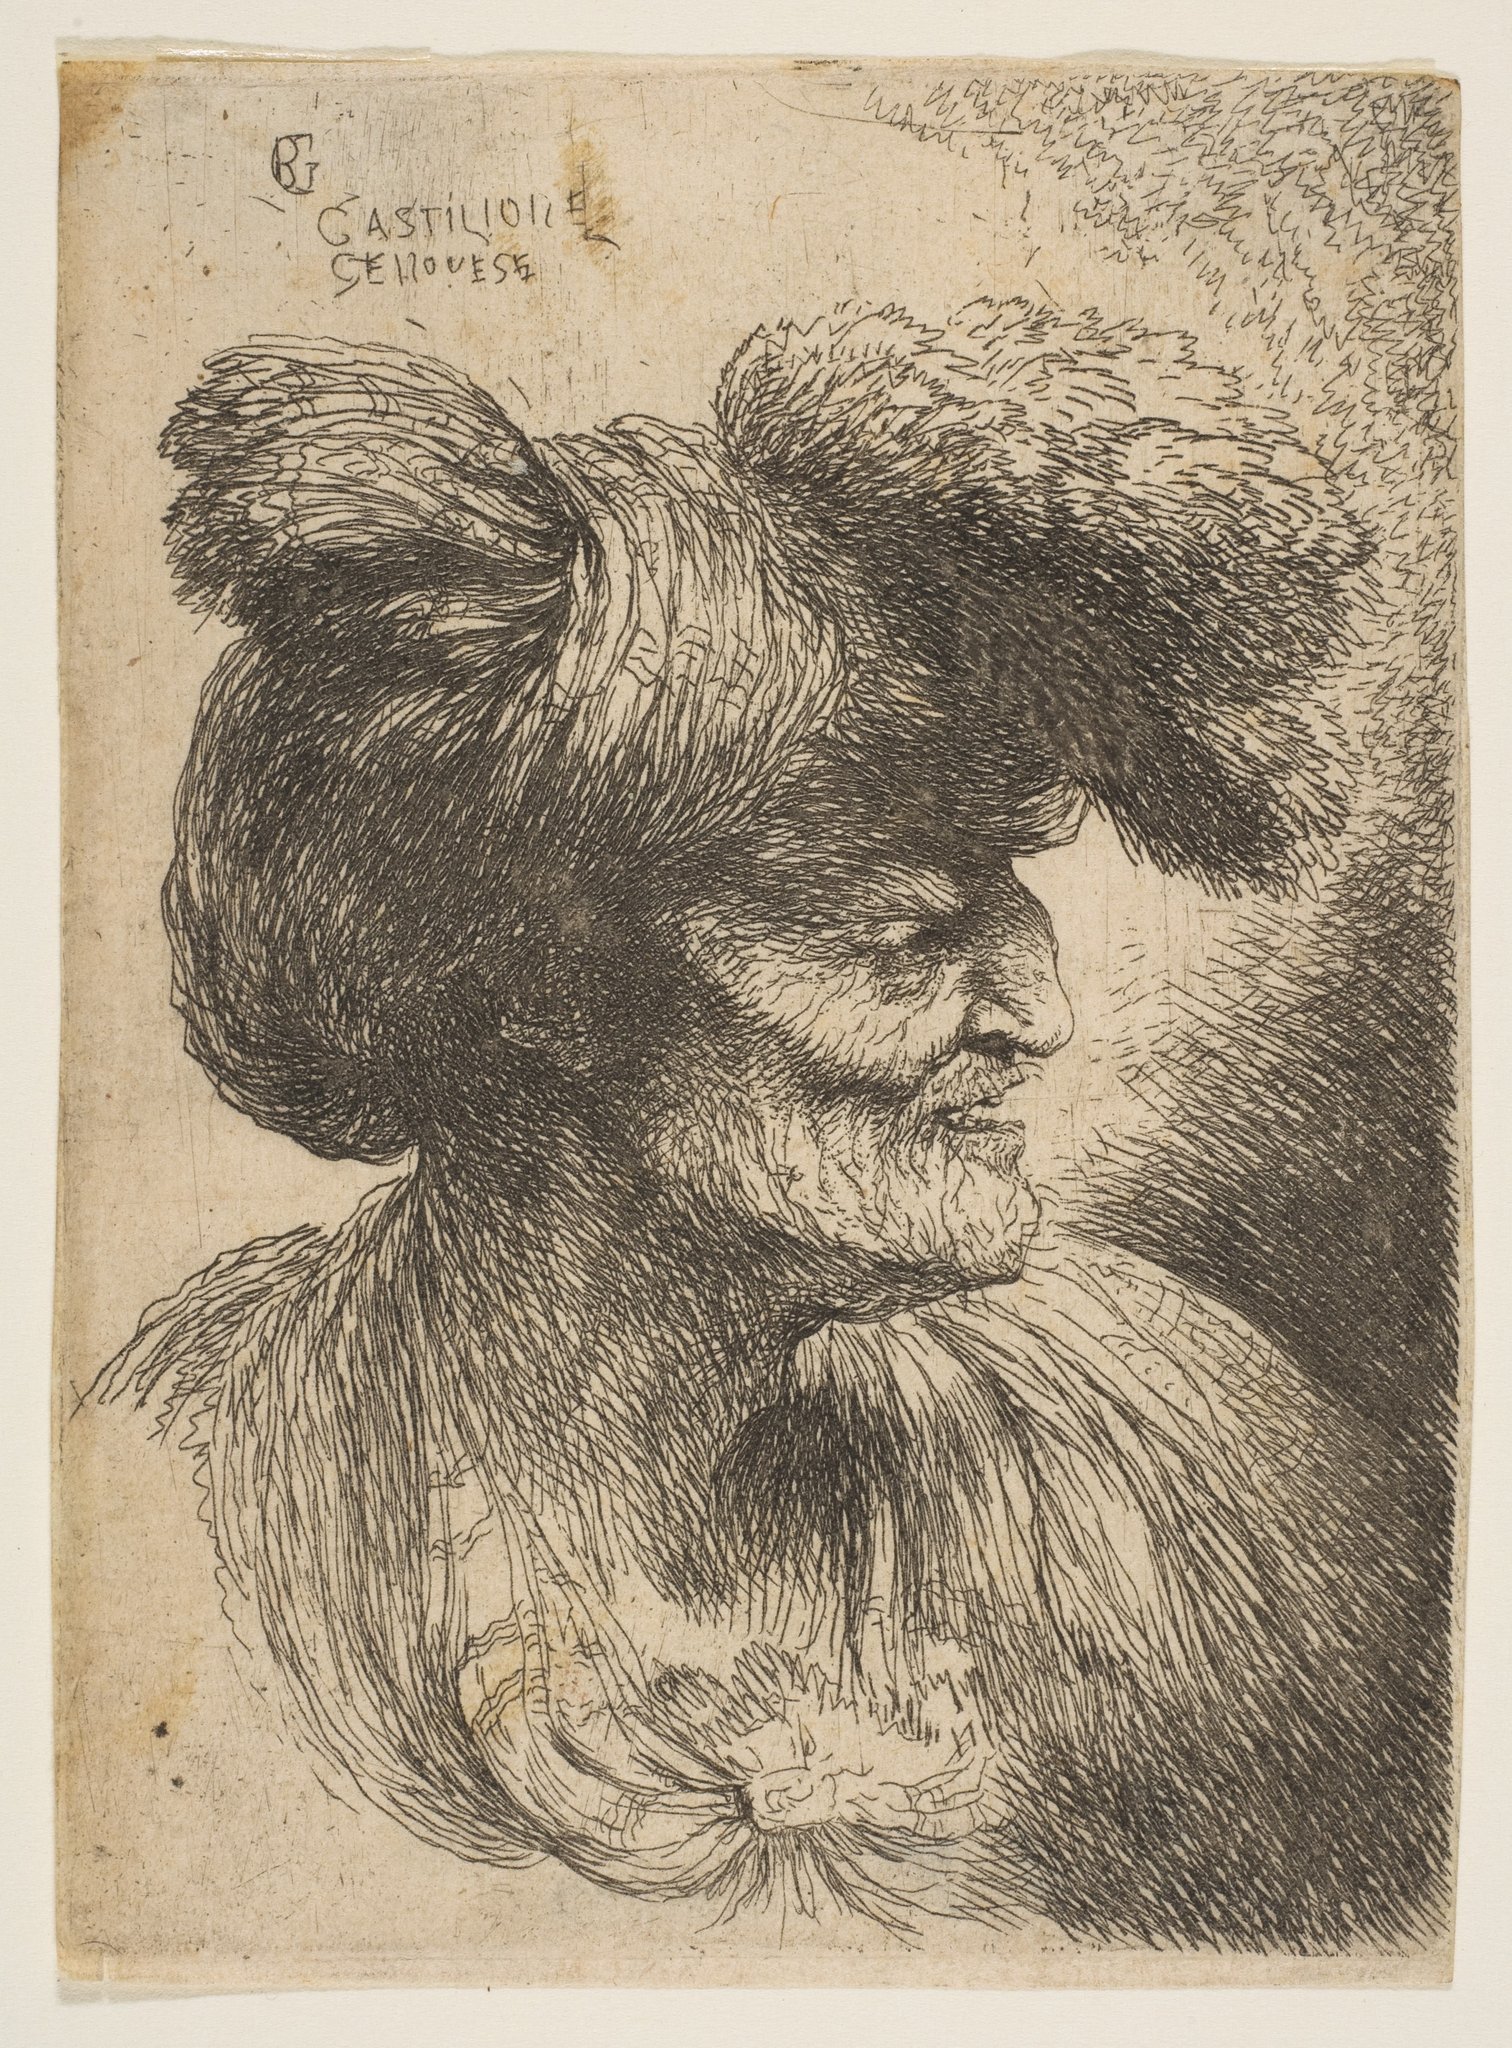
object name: print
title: Bust of beardless old man in profile facing right, from "Small Heads in Oriental Headdress"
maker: giovanni benedetto castiglione (il grechetto)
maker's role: artist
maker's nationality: italian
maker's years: 1609-1664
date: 1645-1650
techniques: etching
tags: profiles